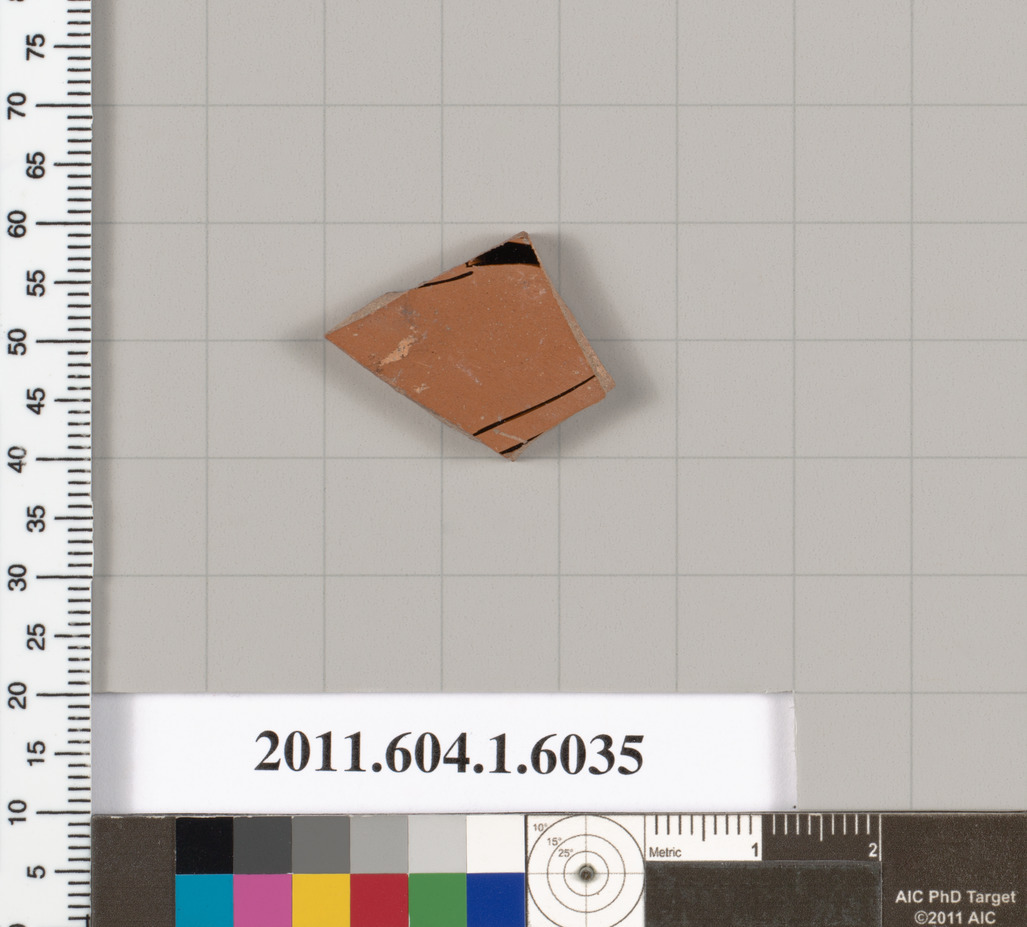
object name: kylix fragment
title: Terracotta fragment of a kylix (drinking cup)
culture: greek, attic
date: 510-500 BCE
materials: terracotta